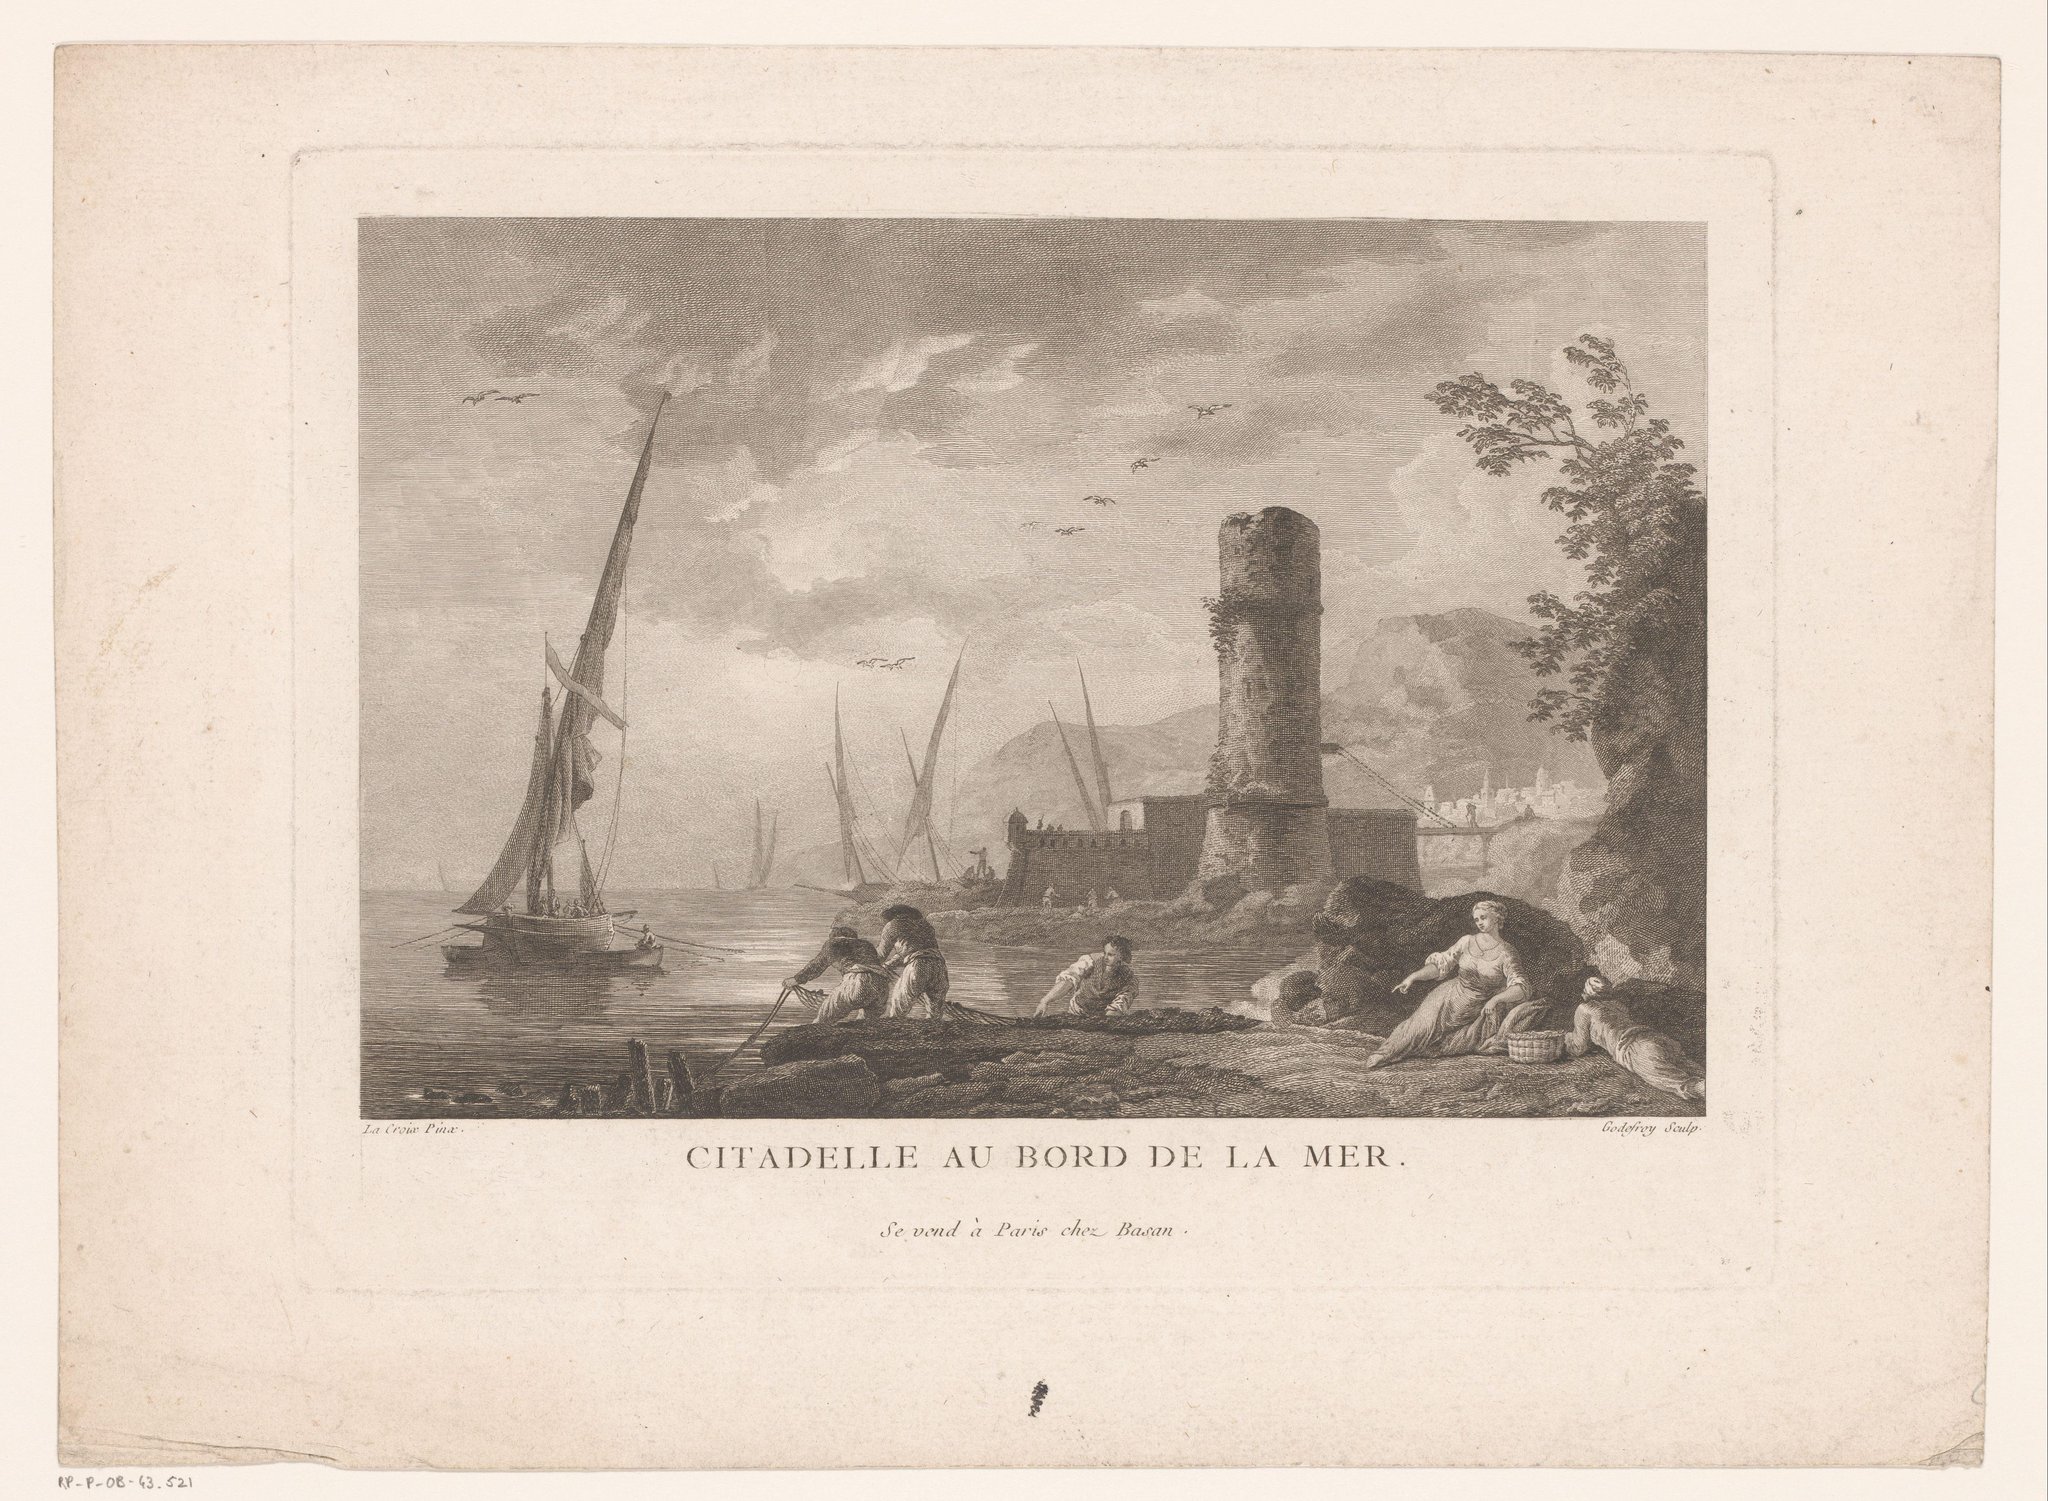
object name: print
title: Vissers bij een fort met toren aan een kust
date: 1787-1802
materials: paper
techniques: etching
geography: paris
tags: fortress, coast, fisherman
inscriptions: collector's mark: Lugt 2228